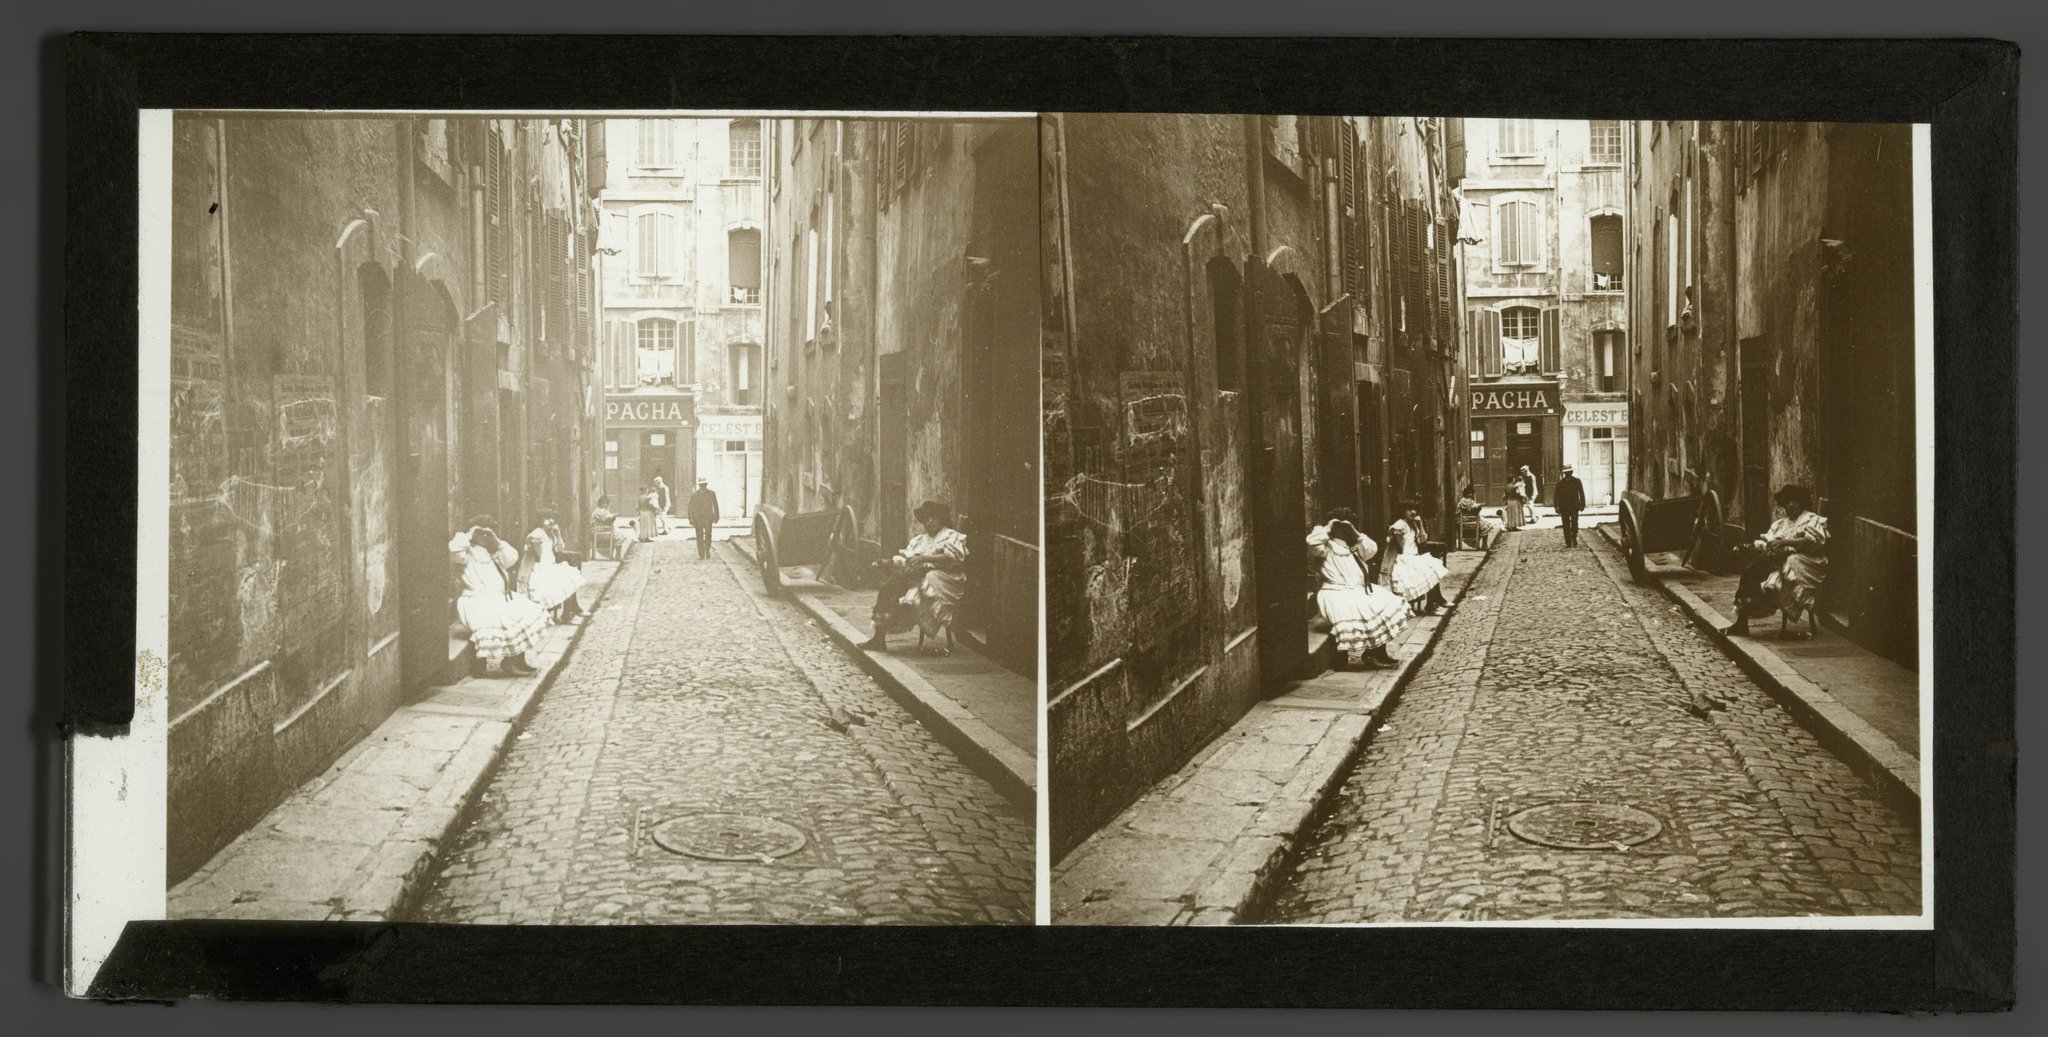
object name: stereoscopic photograph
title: Straatgezicht te Parijs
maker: Anonymous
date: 1860-1900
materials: glass, paper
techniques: slide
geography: paris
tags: street (+ city(-scape) with figures, staffage), paris